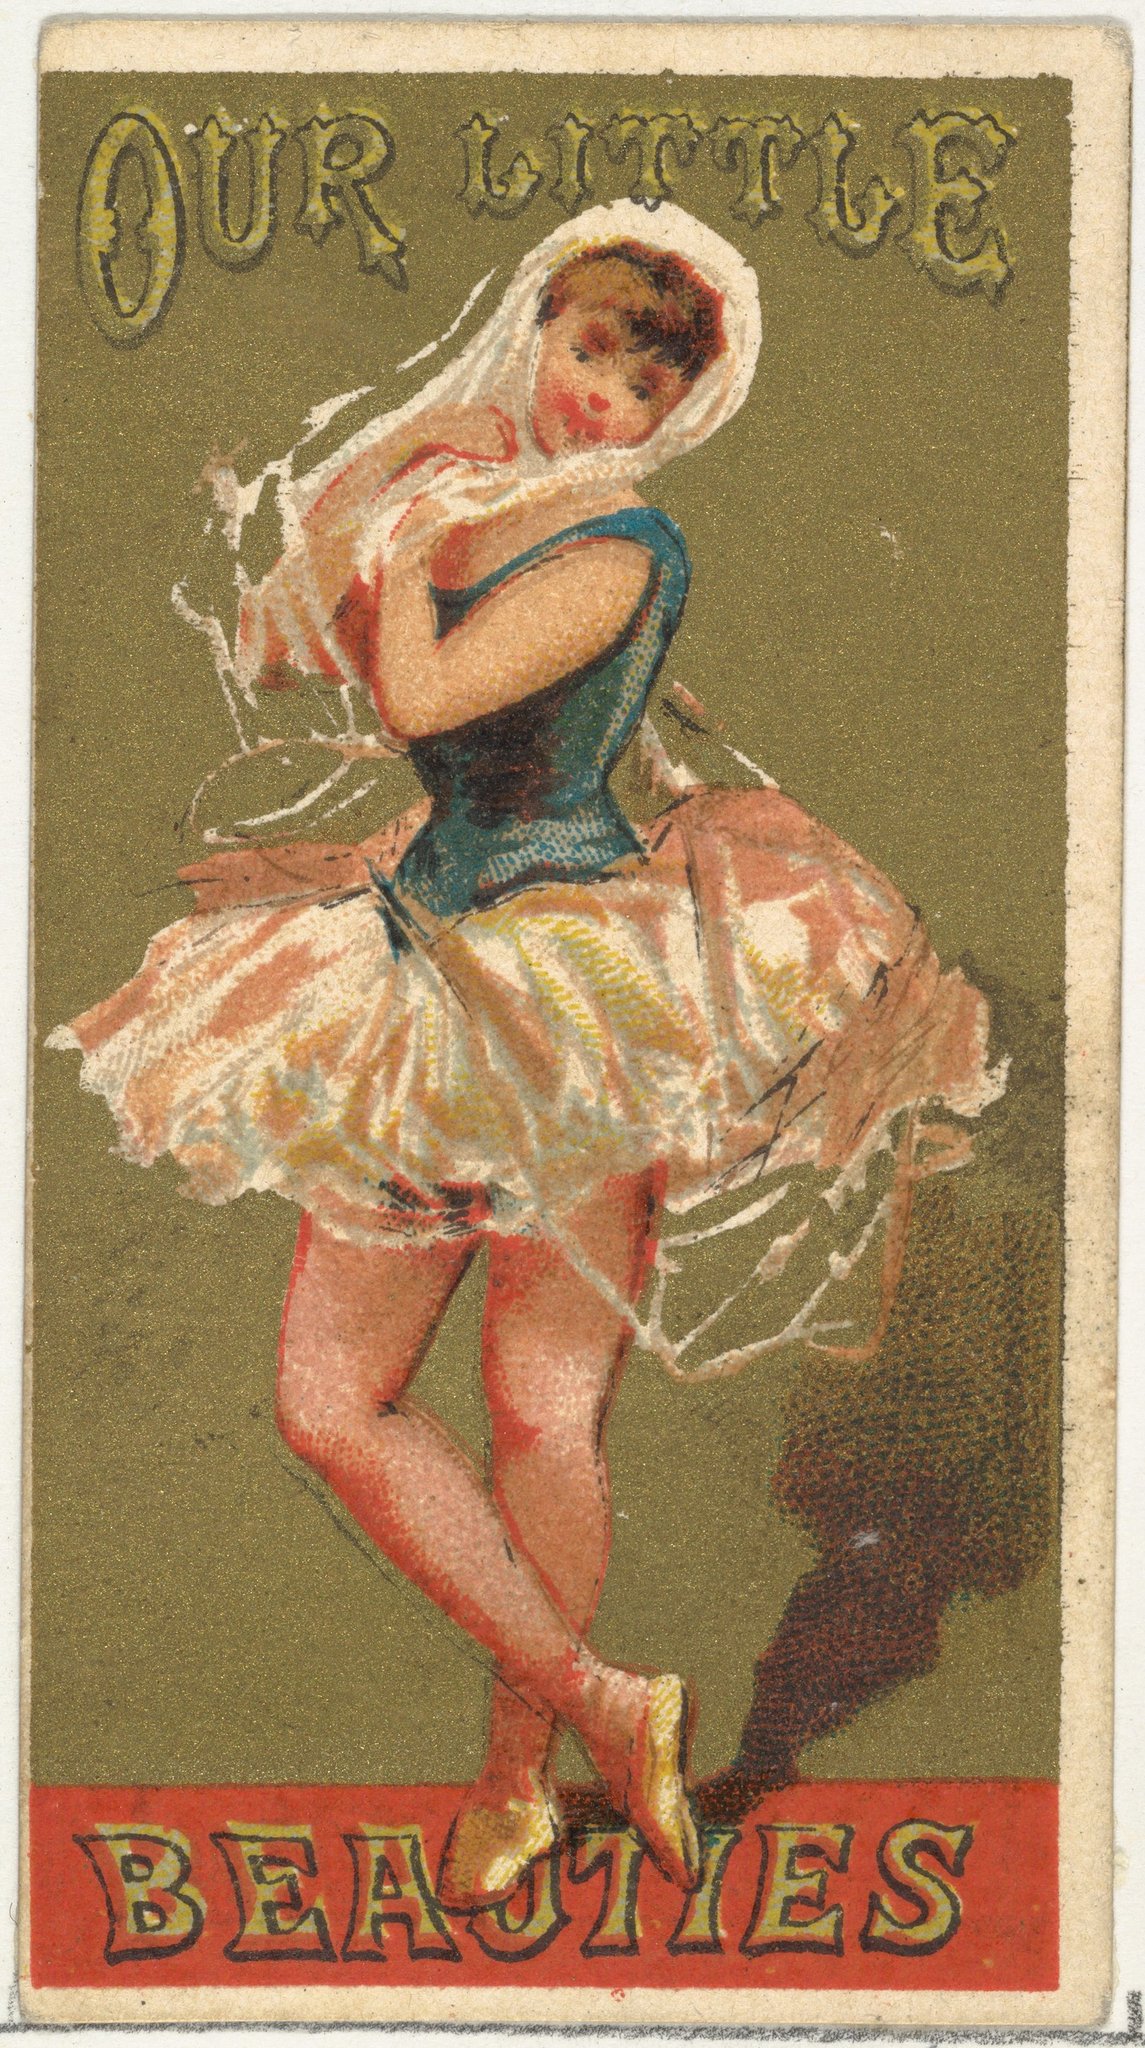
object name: print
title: From the Girls and Children series (N58) promoting Our Little Beauties Cigarettes for Allen & Ginter brand tobacco products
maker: allen & ginter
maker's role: publisher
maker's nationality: american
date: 1887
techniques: color lithograph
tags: girls